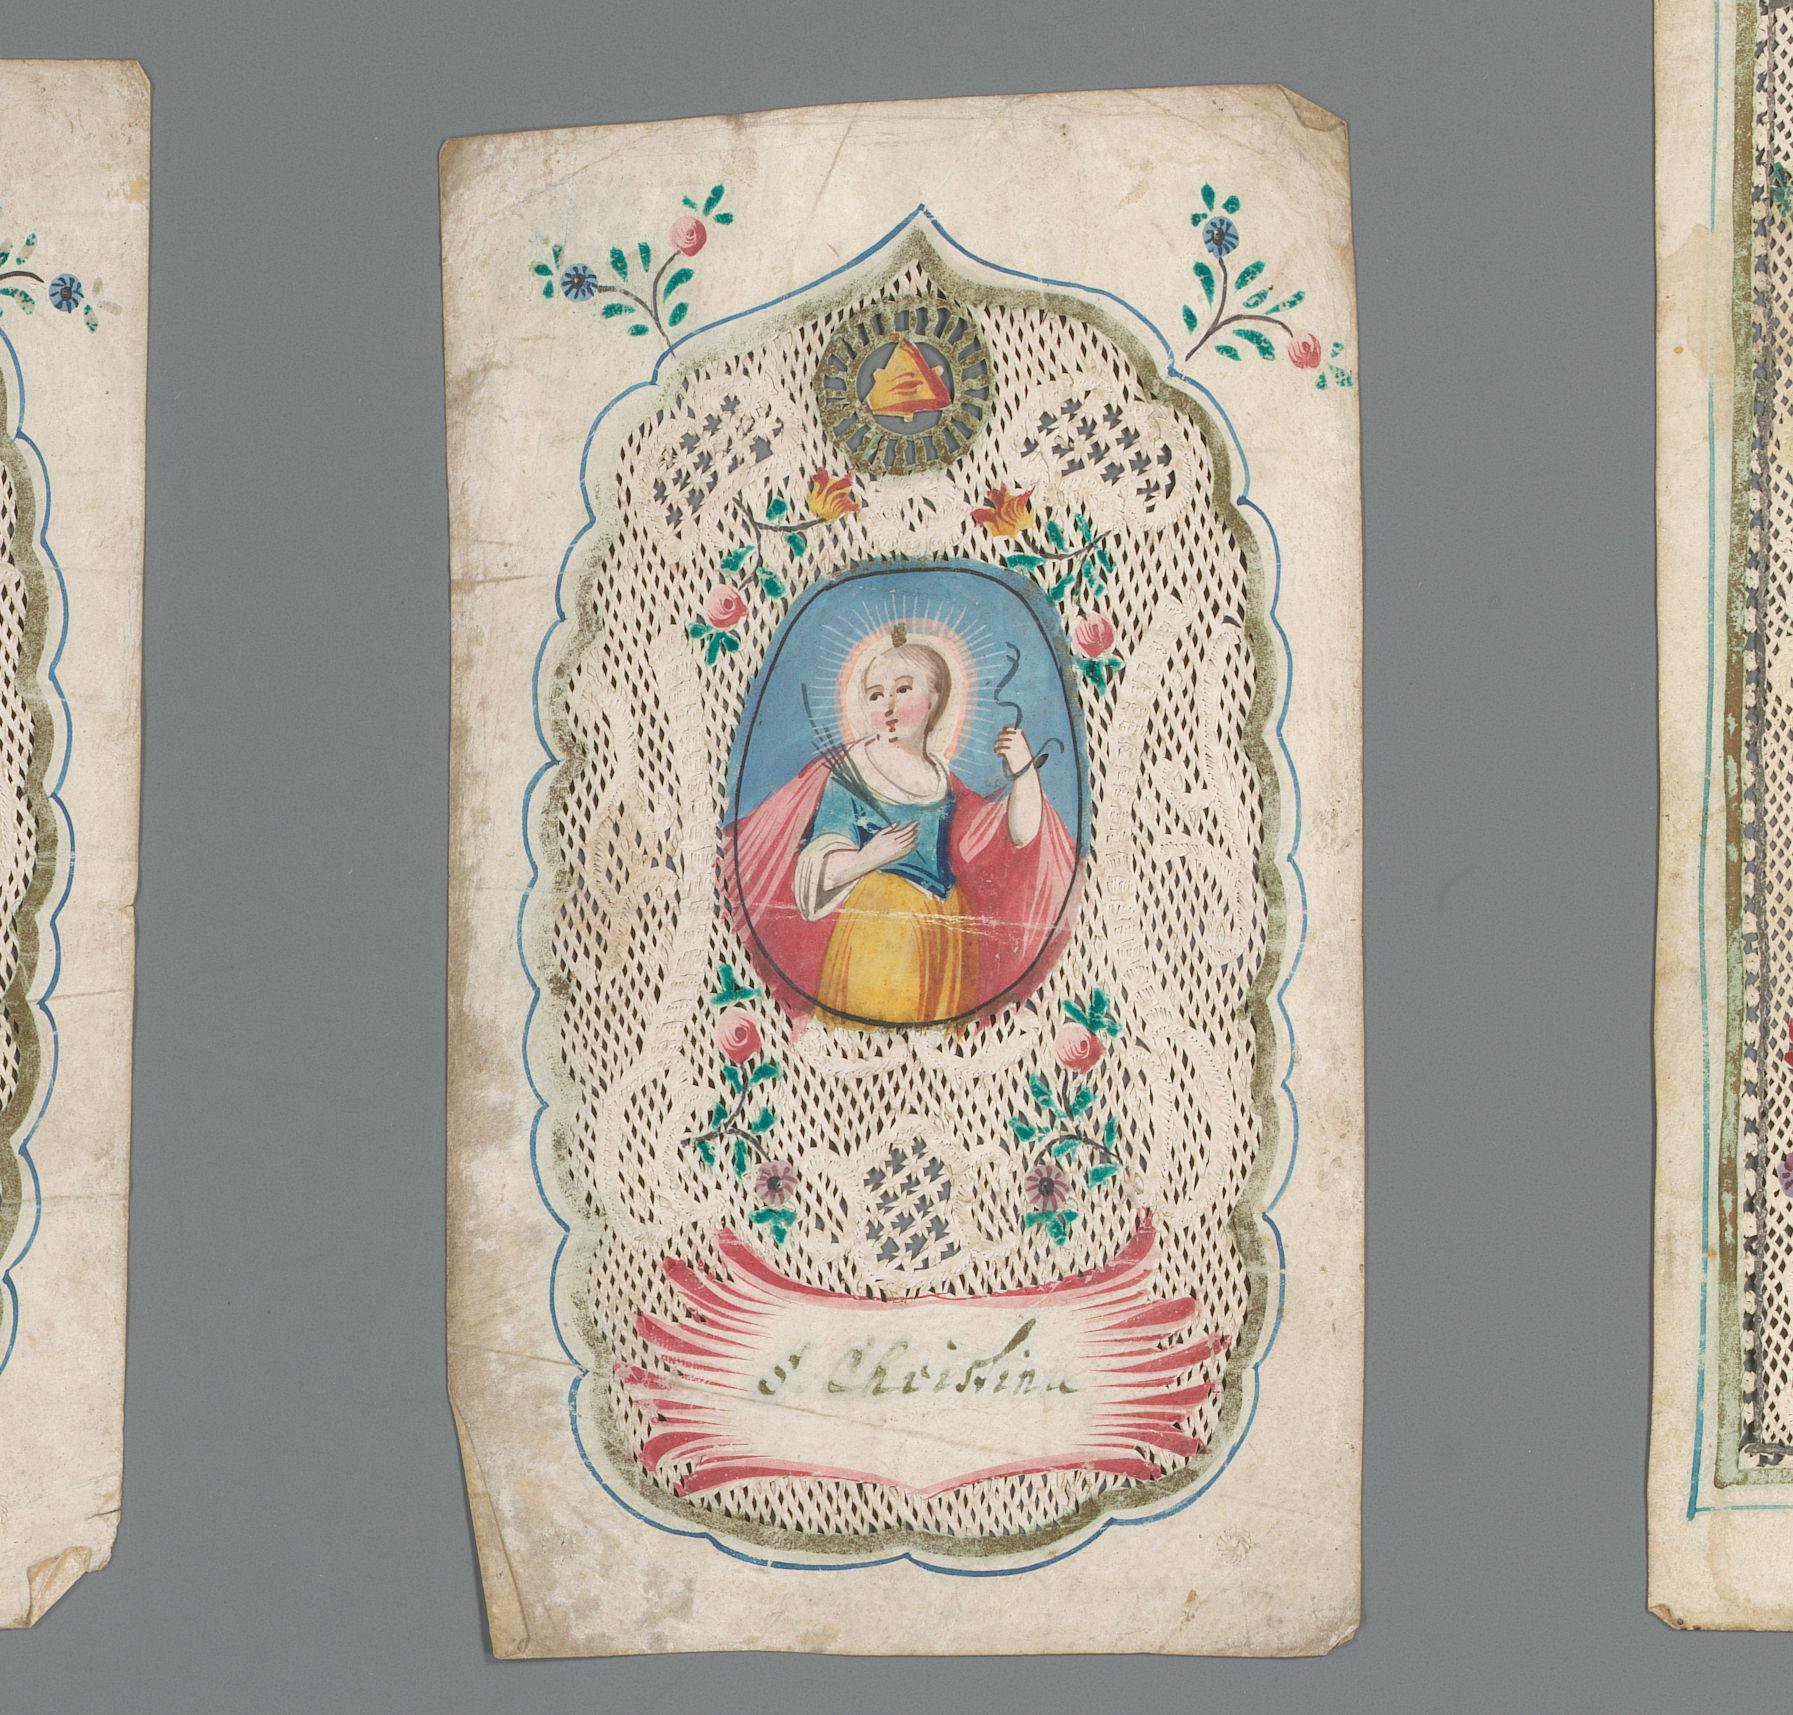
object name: cut paper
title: S. Christina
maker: Anonymous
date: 1750-1784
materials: paper, watercolor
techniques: cutting, drawing, snipping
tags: the virgin martyr christina of bolsena; possible attributes: arrow(s), book, flames, millstone, tongs, snake, wheel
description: De heilige Christina met touw en palmtak in een uitgesneden decoratieve omlijsting met bloemen en krullen. Beneden een cartouche met de naam van de heilige.